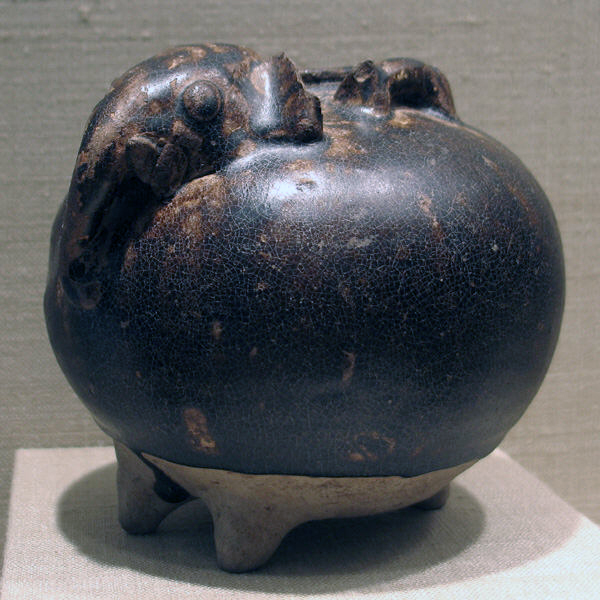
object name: lime pot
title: Lime Pot in the Form of an Elephant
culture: thailand, buriram province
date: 1067-1200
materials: stoneware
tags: elephants